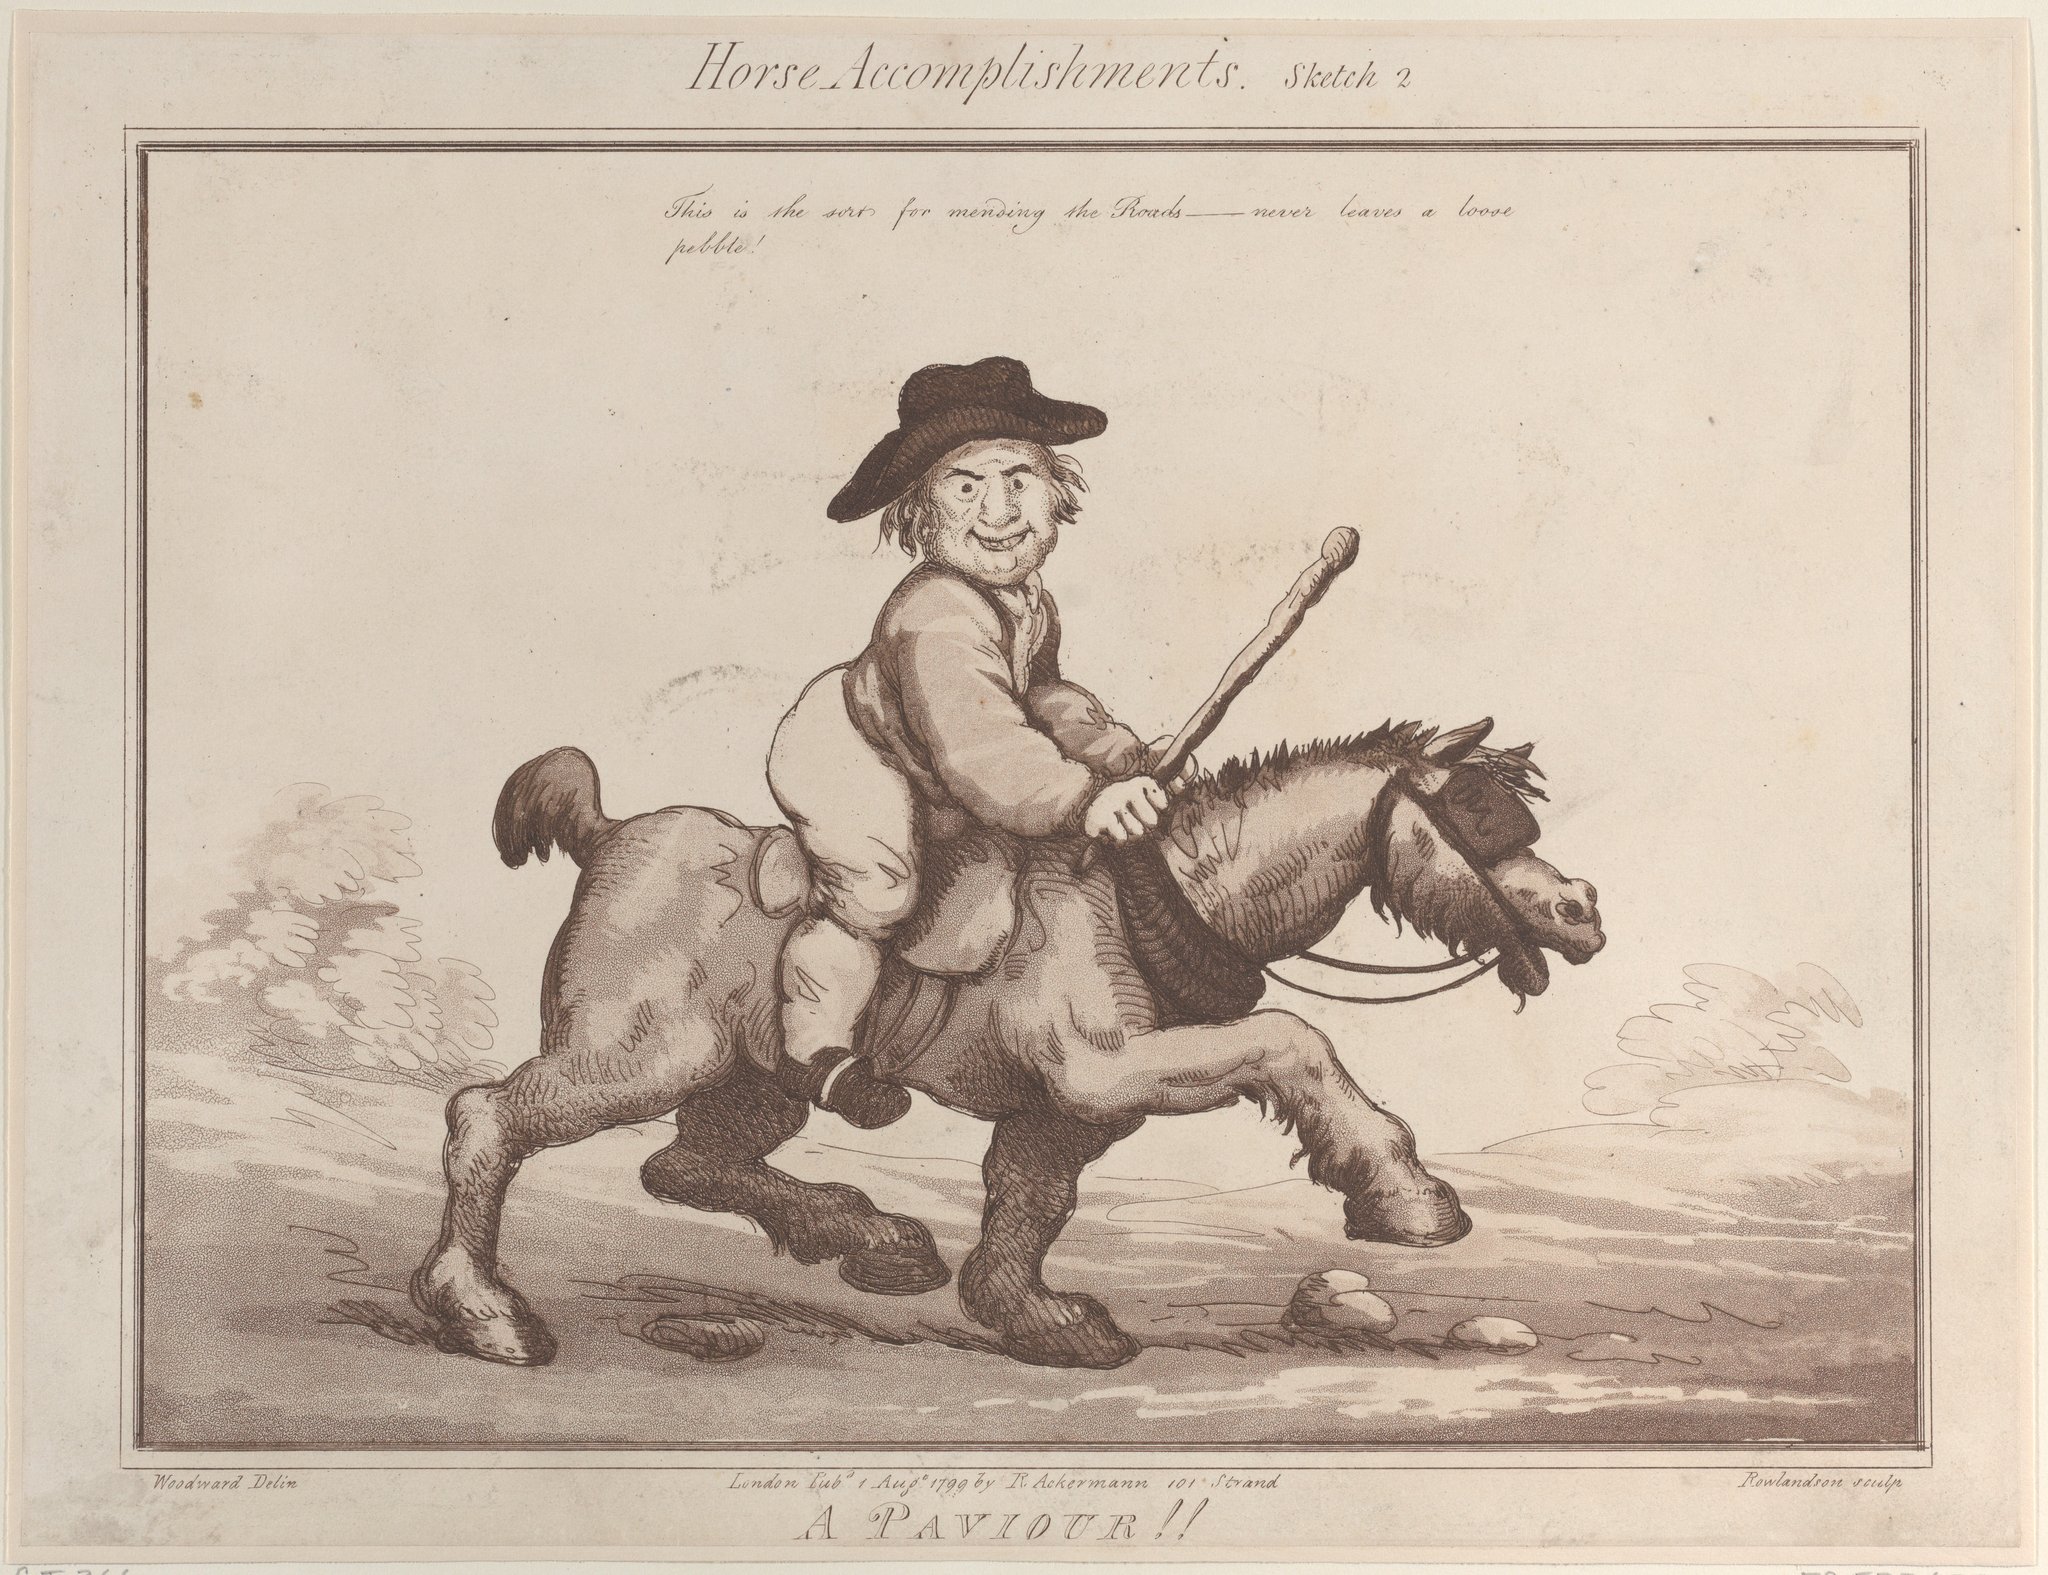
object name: print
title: Horse Accomplishments, Sketch 2: A Paviour !!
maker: thomas rowlandson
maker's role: artist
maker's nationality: british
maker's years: 1757-1827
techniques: aquatint, etching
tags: satire,men,horses,caricature